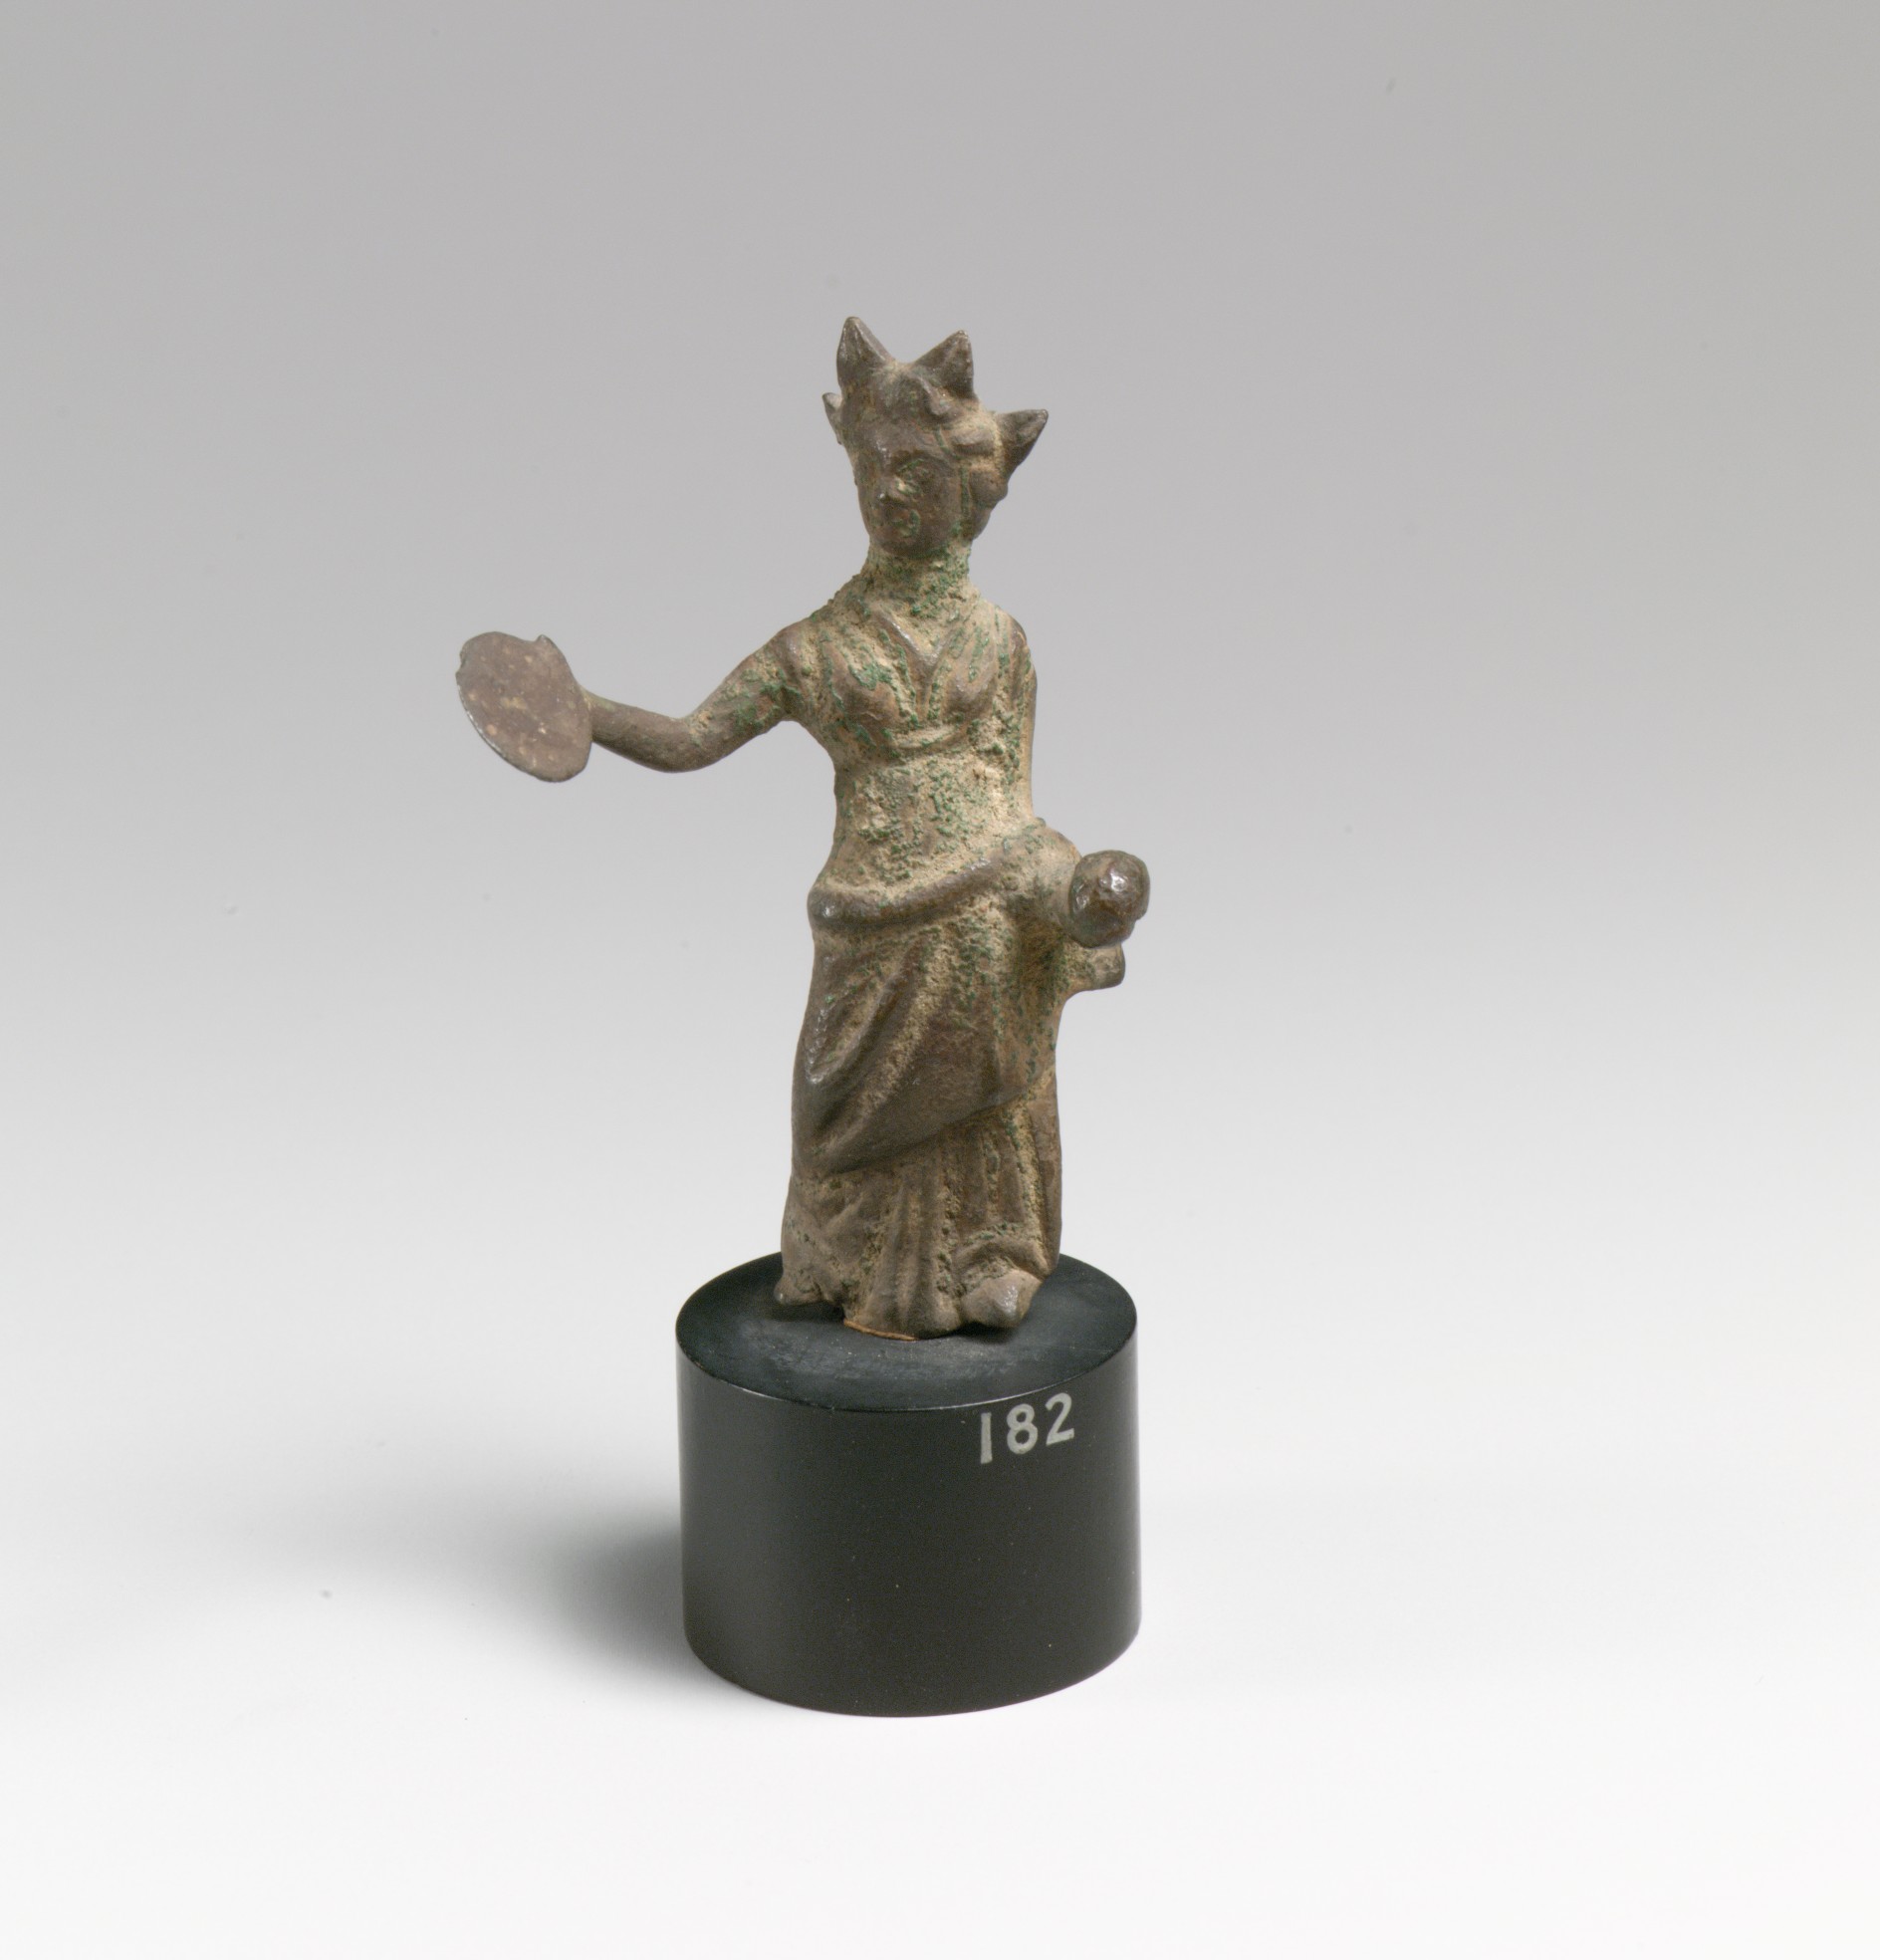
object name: statuette of a woman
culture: italic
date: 300-1 BCE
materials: bronze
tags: diadems,women